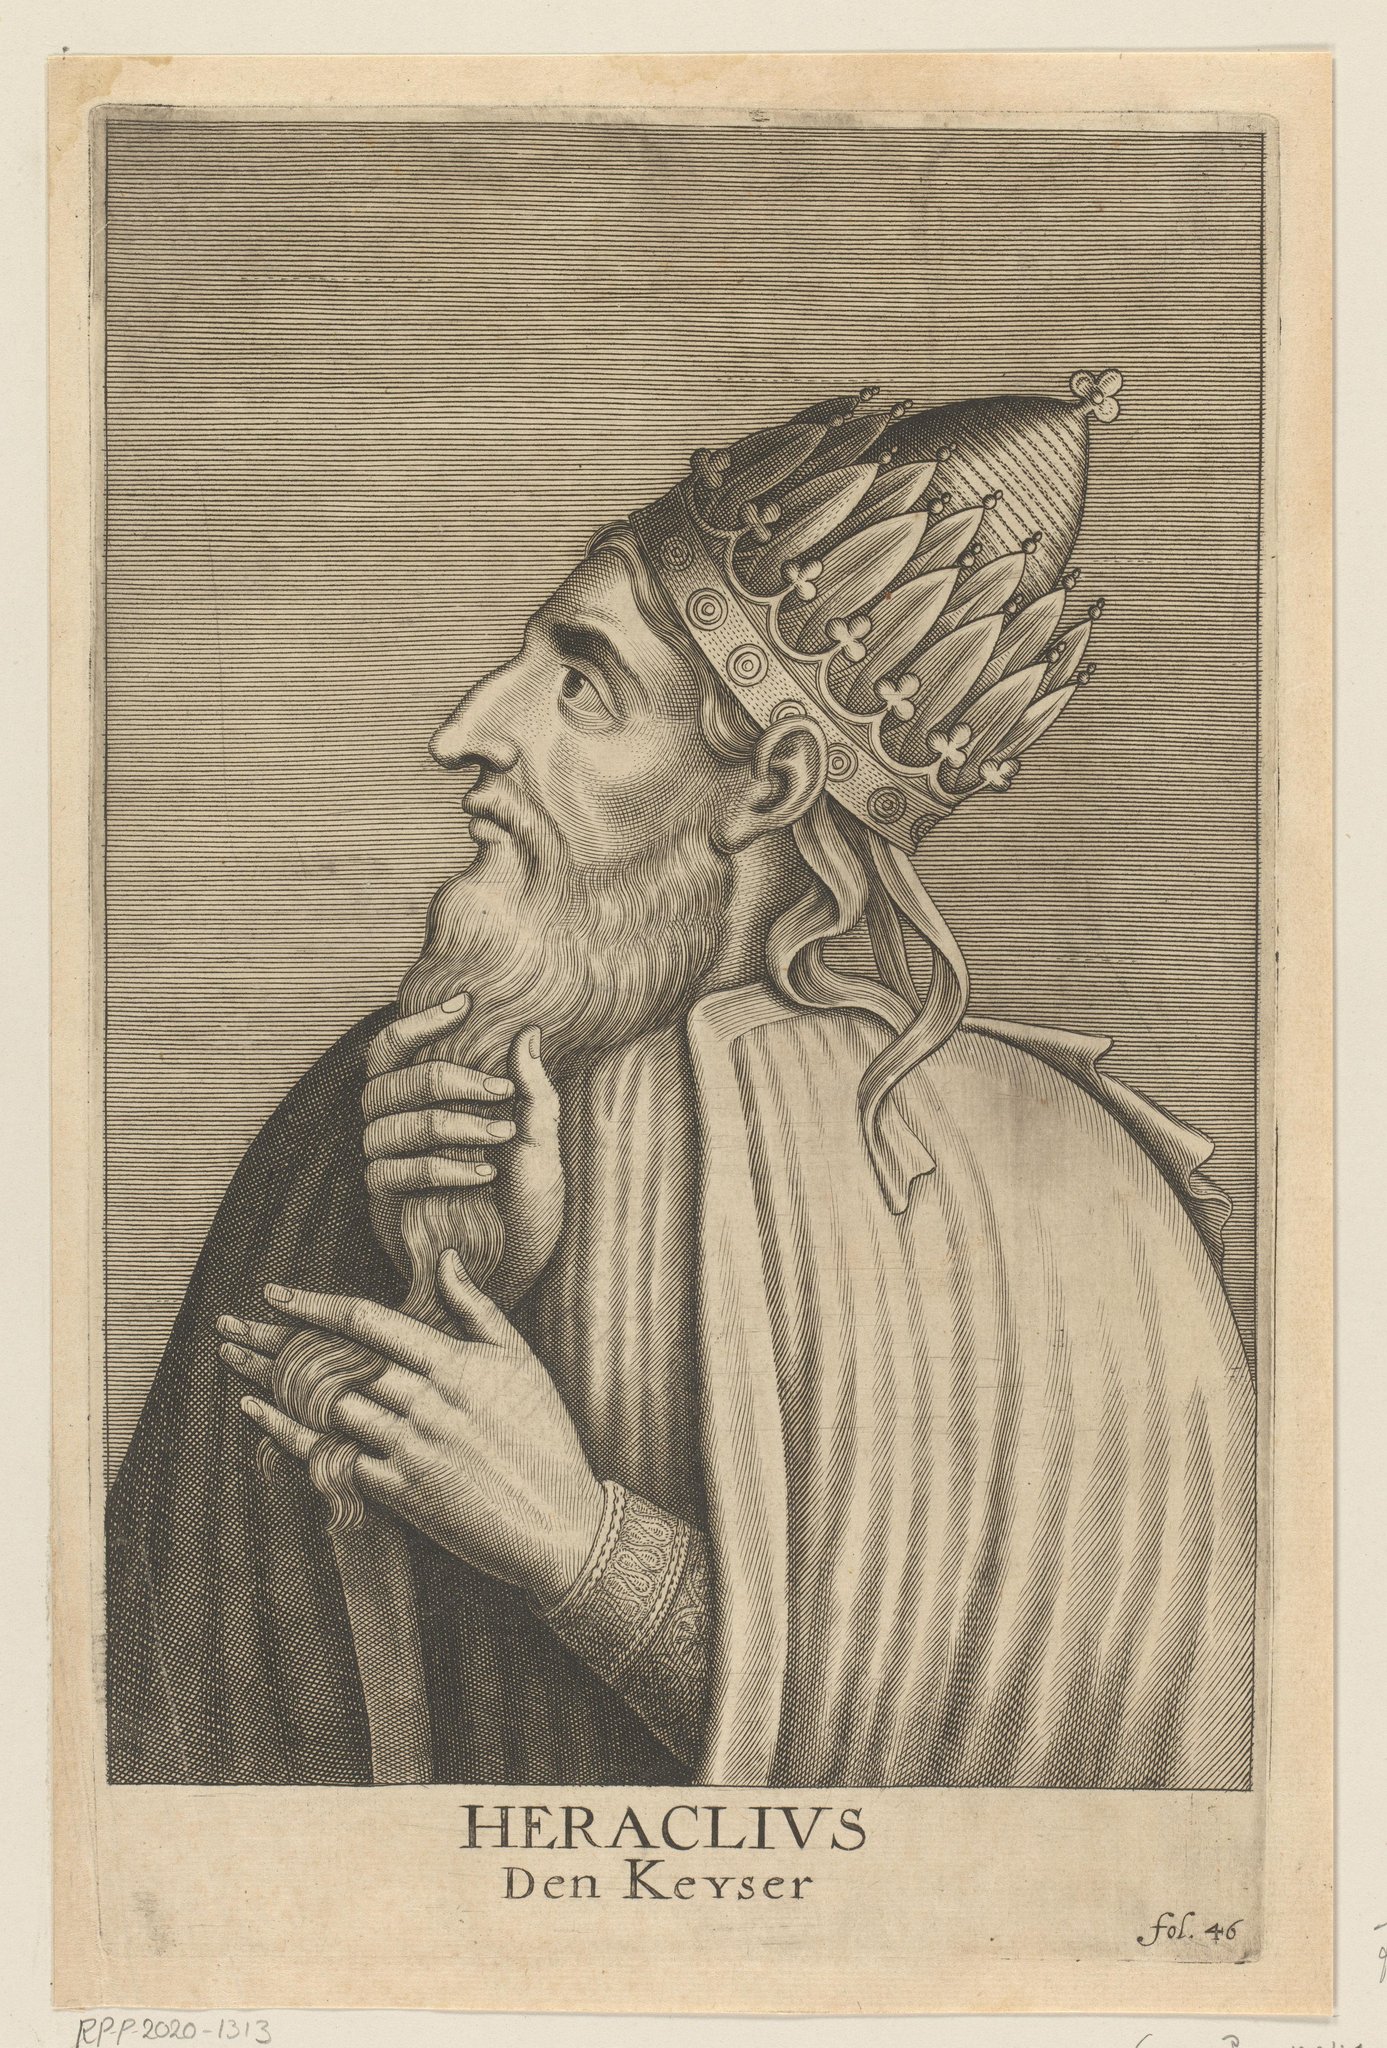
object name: print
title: Portret van Herakleios, keizer van het Romeinse Rijk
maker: Anonymous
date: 1671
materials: paper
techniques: engraving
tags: historical persons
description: Prent ook gebruikt in: Hazart, Cornelius. Kerckelycke historie van de gheheele wereldt (...). 4 dln. Antwerpen: Michiel Cnobbaert, 1671, dl. 4.